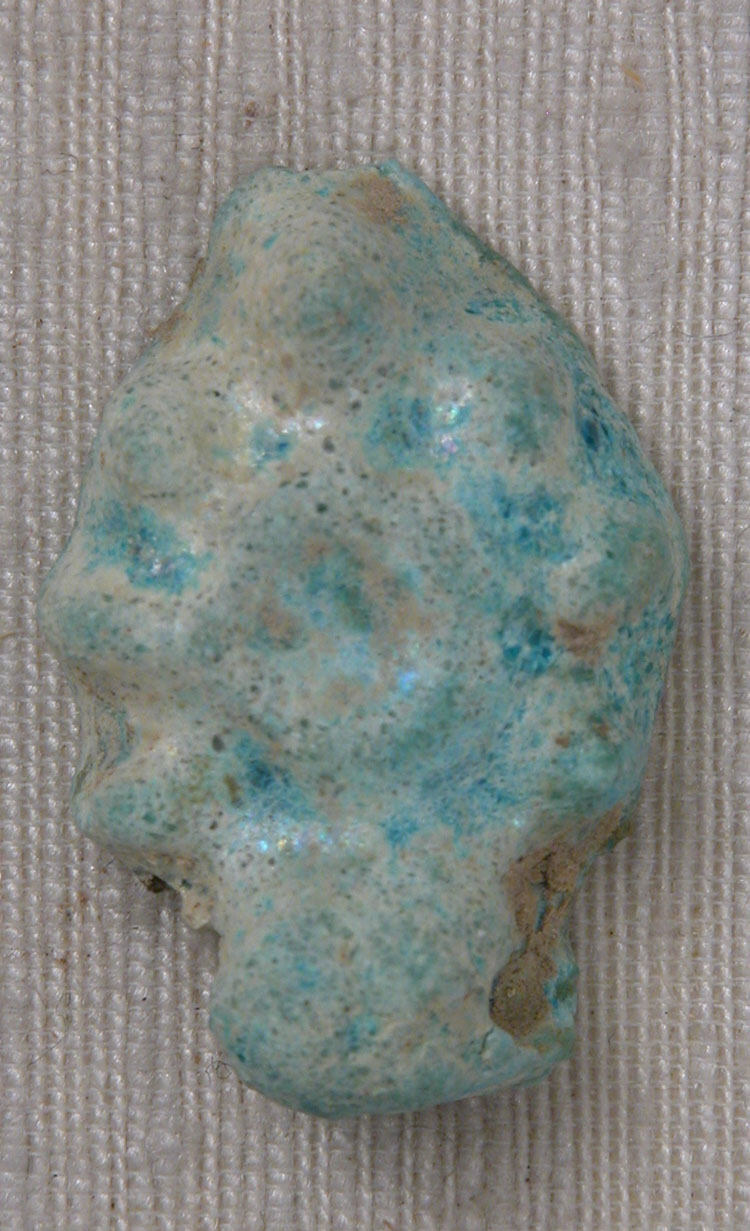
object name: bead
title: Beads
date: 701-1300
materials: earthenware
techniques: glazing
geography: iran